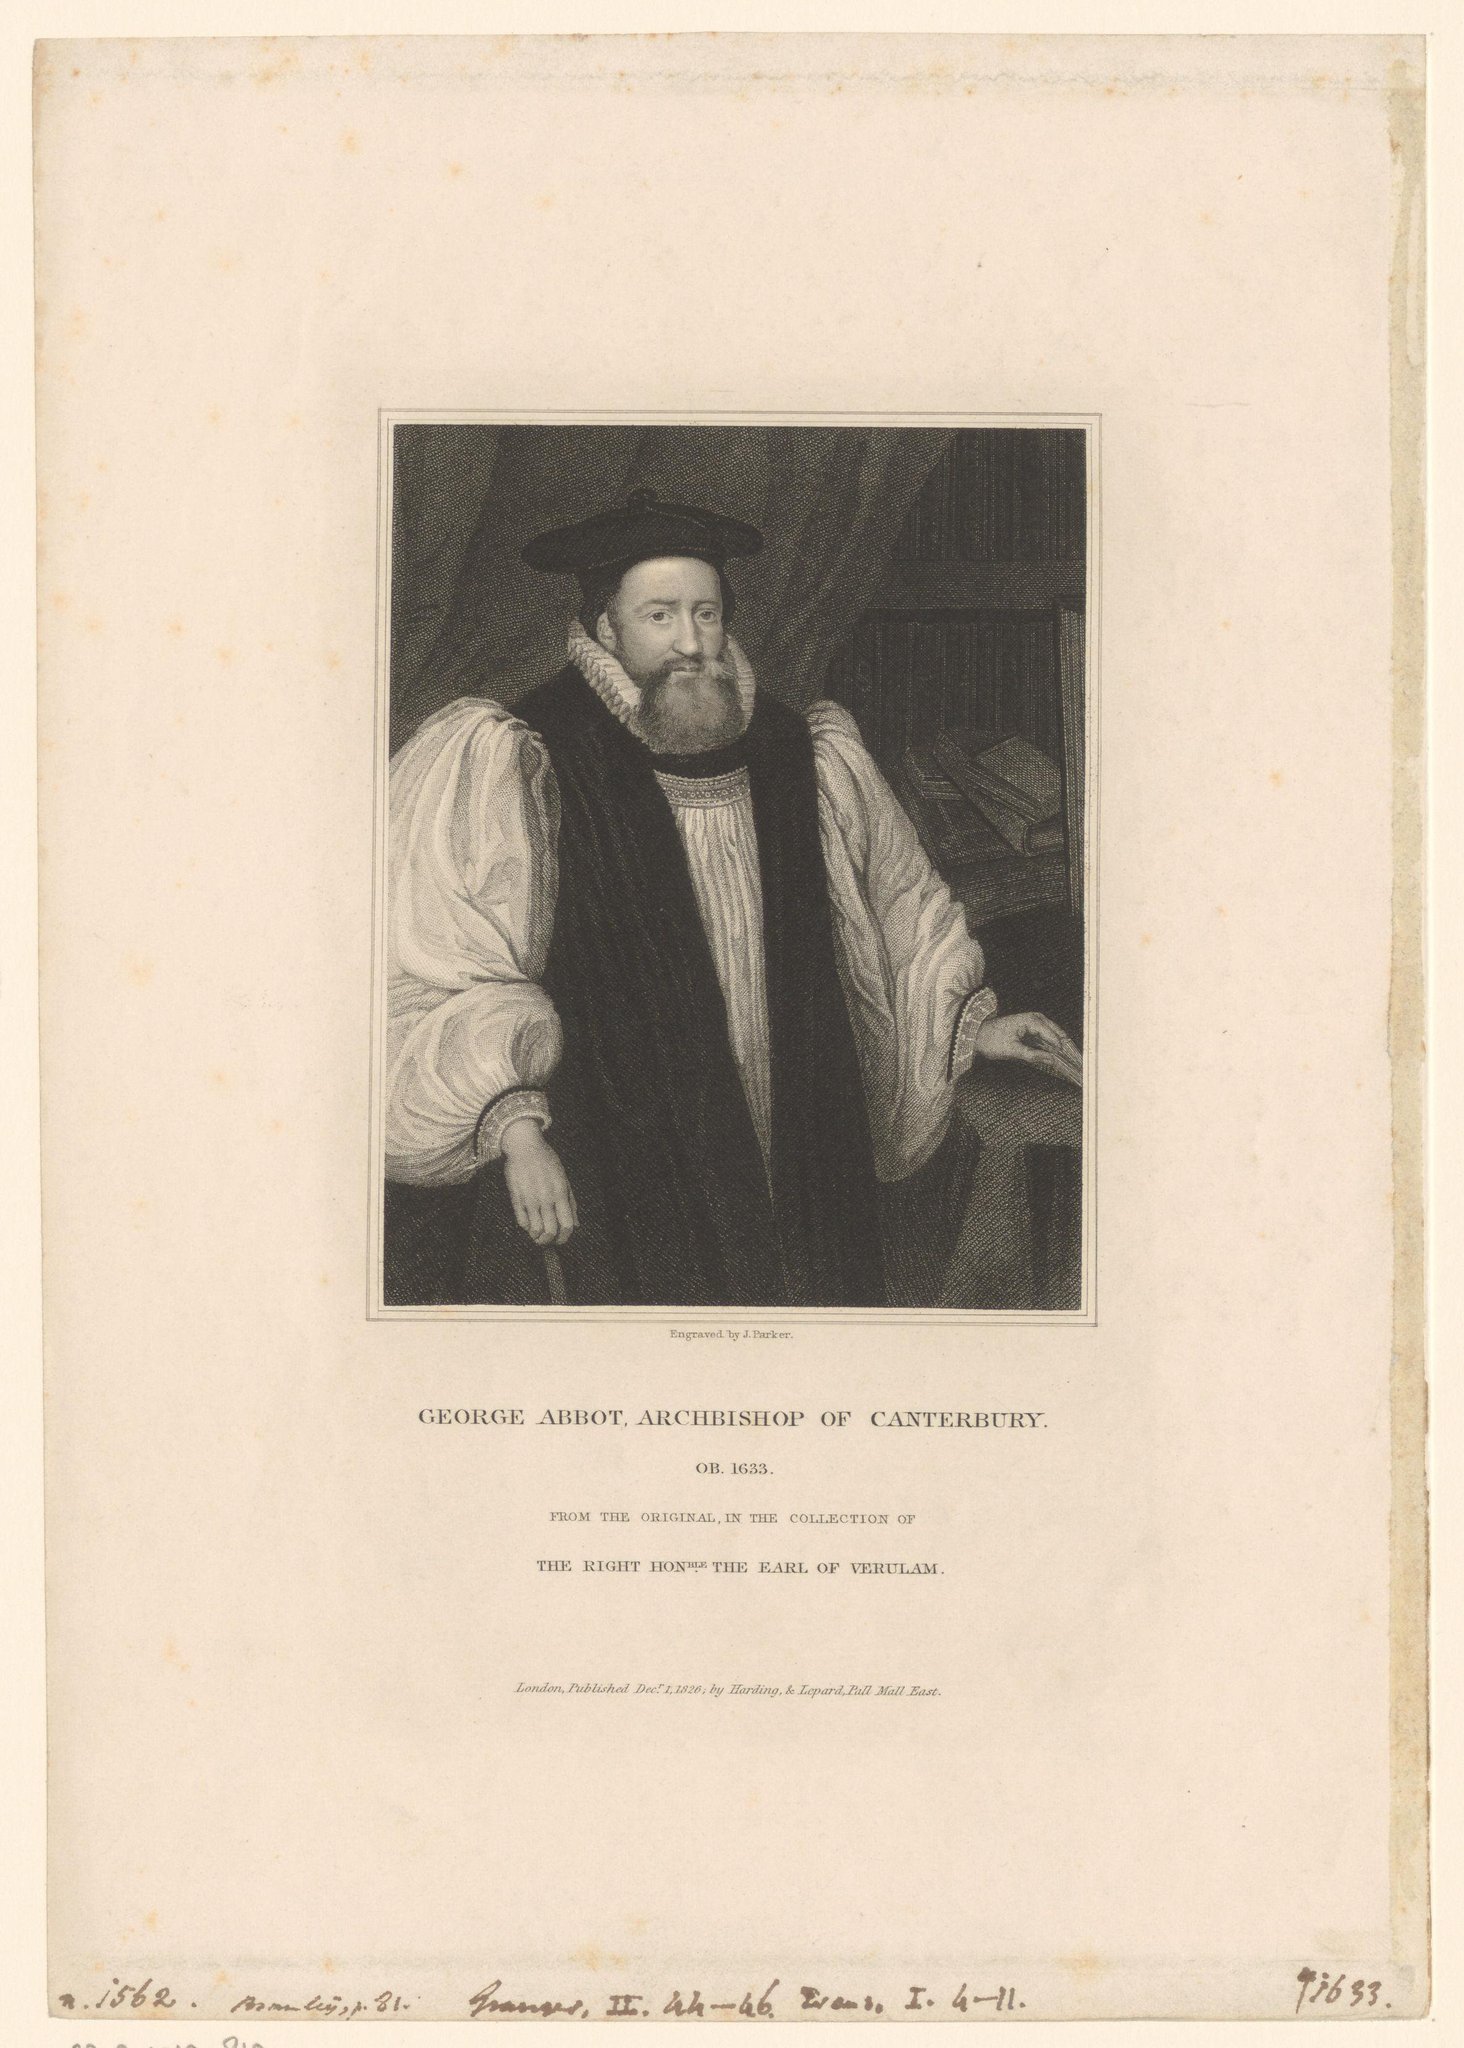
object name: print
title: George Abbot, Archbishop of Canterbury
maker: james parker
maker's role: print maker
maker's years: 1750-1805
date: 1826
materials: paper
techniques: etching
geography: london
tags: archbishop, bishop, etc. (roman catholic), historical persons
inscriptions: collector's mark: Lugt 2228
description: Prent uit: Lodge, Edmund. Portraits of Illustrious Personages of Great Britain. Londen: Harding & Lepard, 1826, dl. 5.